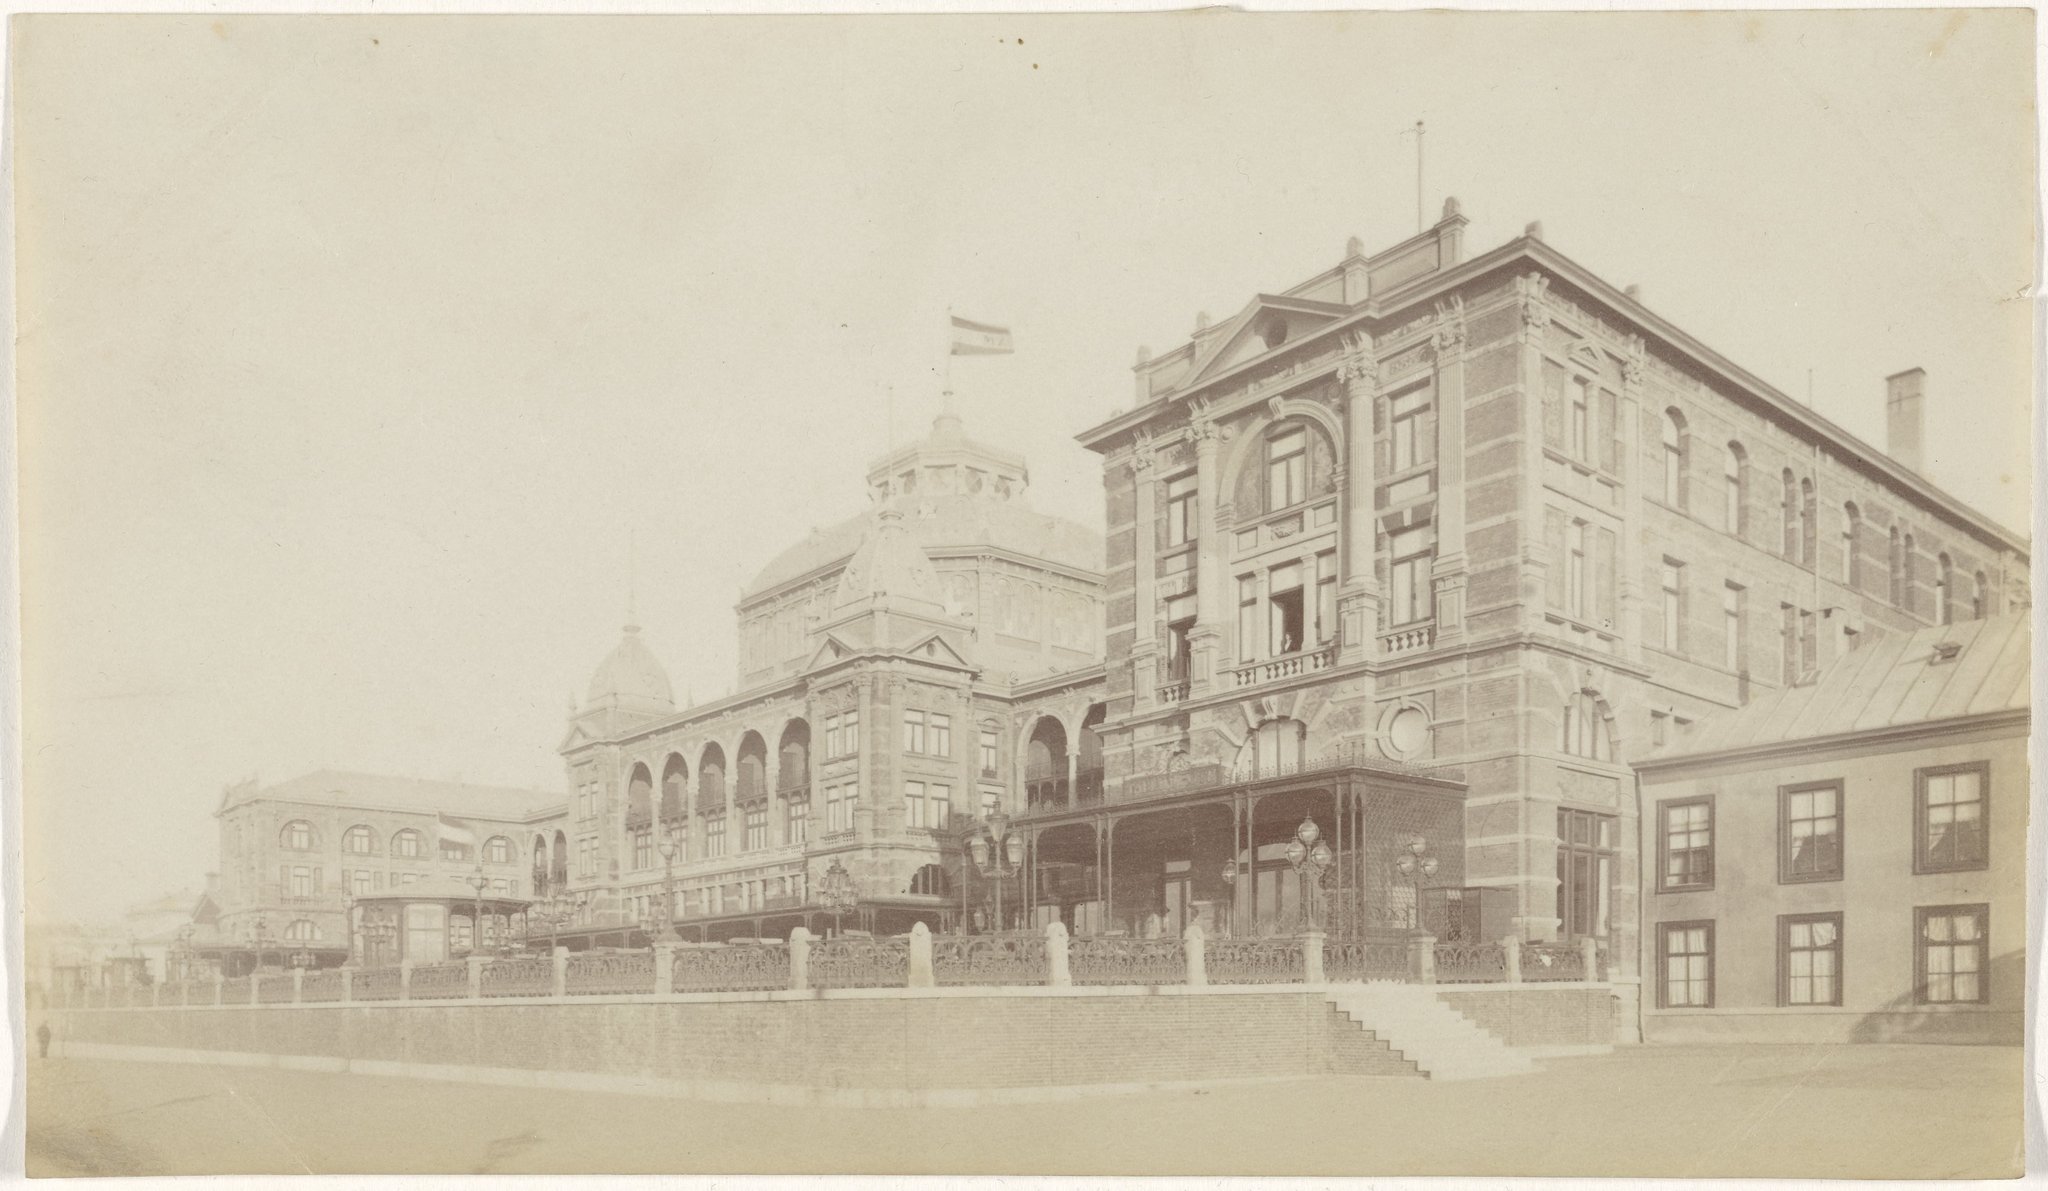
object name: photograph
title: Gezicht op het Kurhaus in Scheveningen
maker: Anonymous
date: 1887-1900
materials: paper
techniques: albumen print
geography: scheveningen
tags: public baths